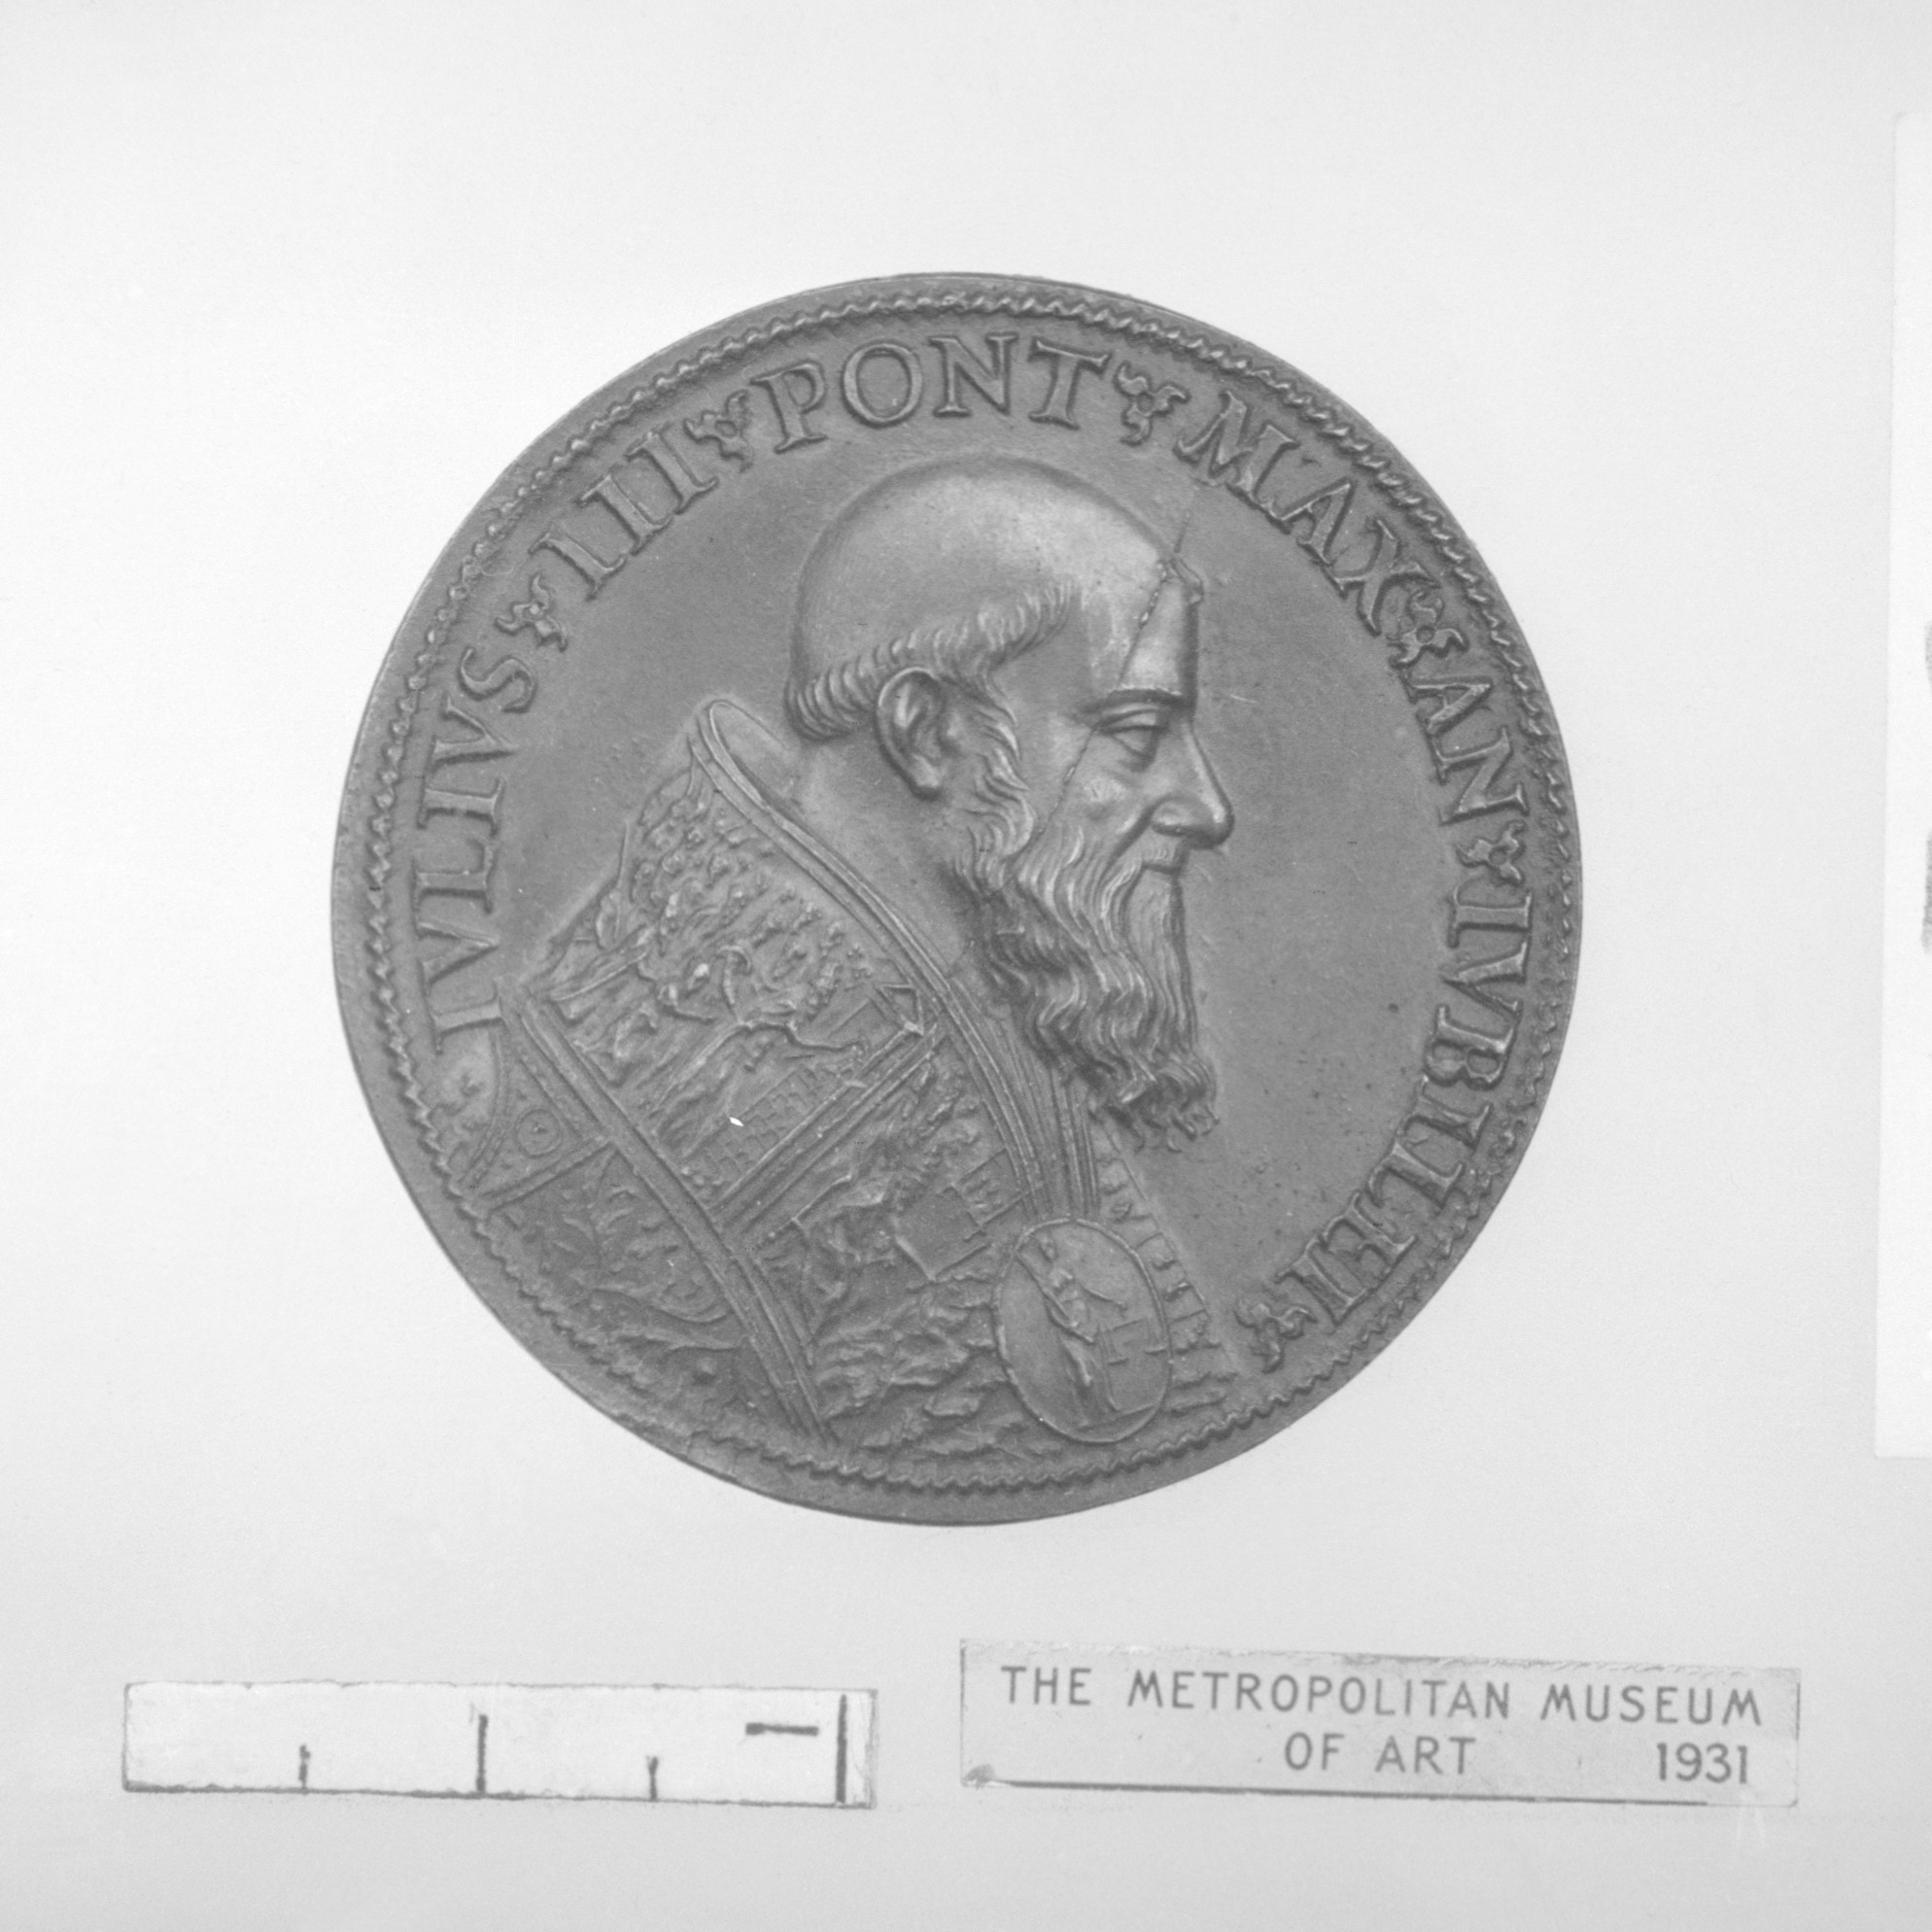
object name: medal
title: Julius III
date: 1501-1600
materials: bronze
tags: men,profiles